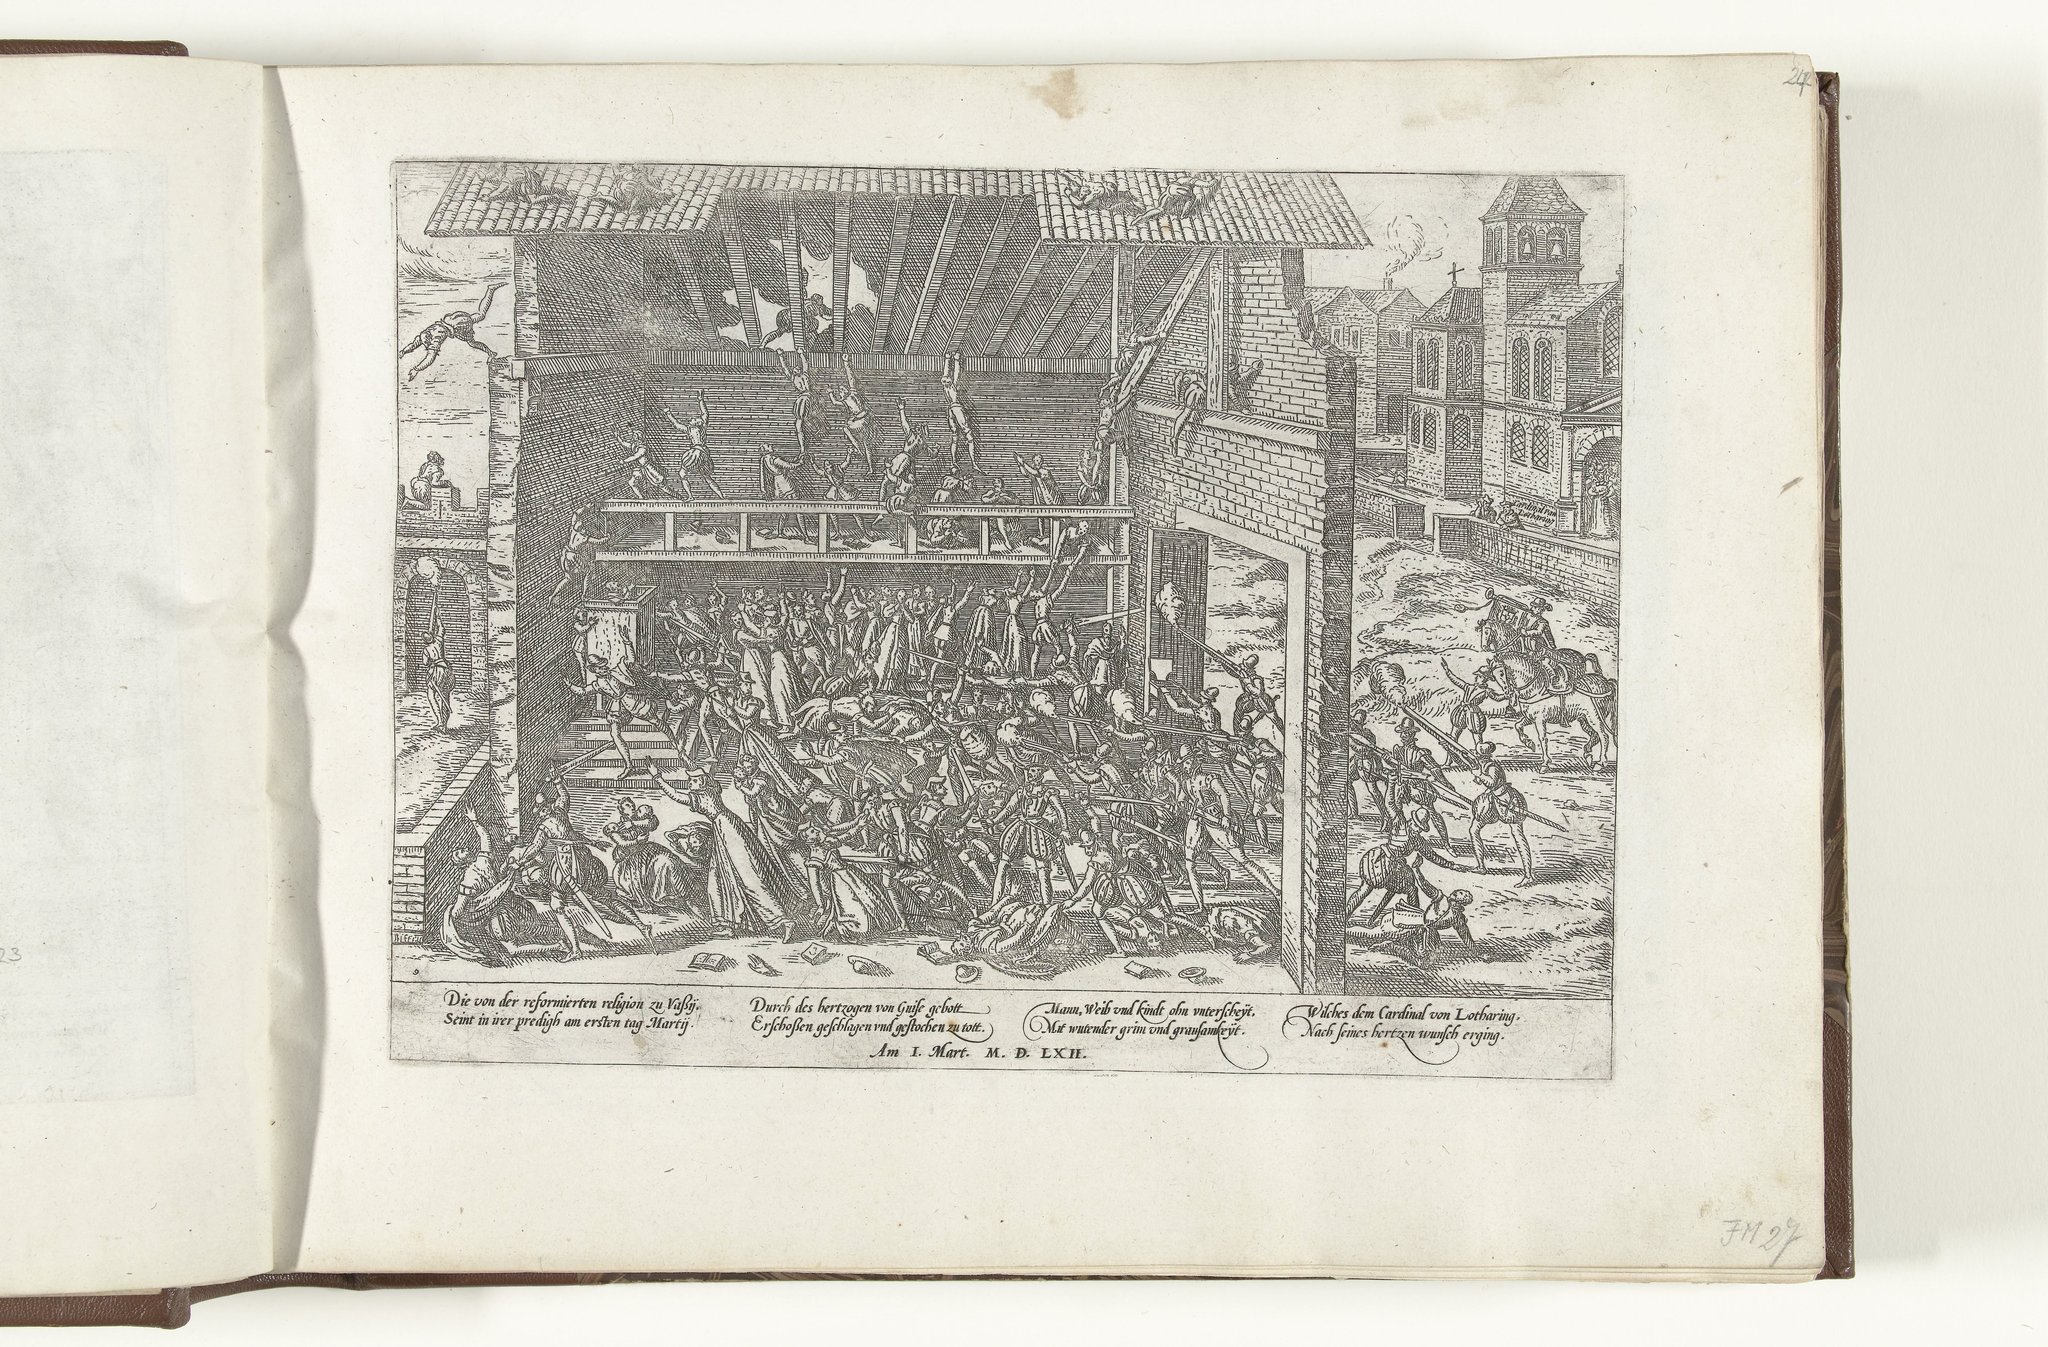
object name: history print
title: Serie 3: Franse Godsdienstoorlogen, 1559-1573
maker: frans hogenberg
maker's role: print maker, publisher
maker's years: 1538-1590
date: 1565-1573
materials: paper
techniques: etching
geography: cologne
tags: massacre ~ war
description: Gekopieerd naar de prent in: Jean Tortorel et Jacques Perrissin, Premier volume contenant quarante tableaux ou Histoires diverses qui sont memorables touchant les Guerres, Massacres et Troubles advenus en France en ces dernieres annees : le tout recueilly selon le tesmoignange de ceux qui y ont esté en personne et qui les ont veus : lesquels sont pourtraits à la vérité, Genève ca. 1570. Bibliotheek Rijksmuseum: 329 A 2, pl. 11.